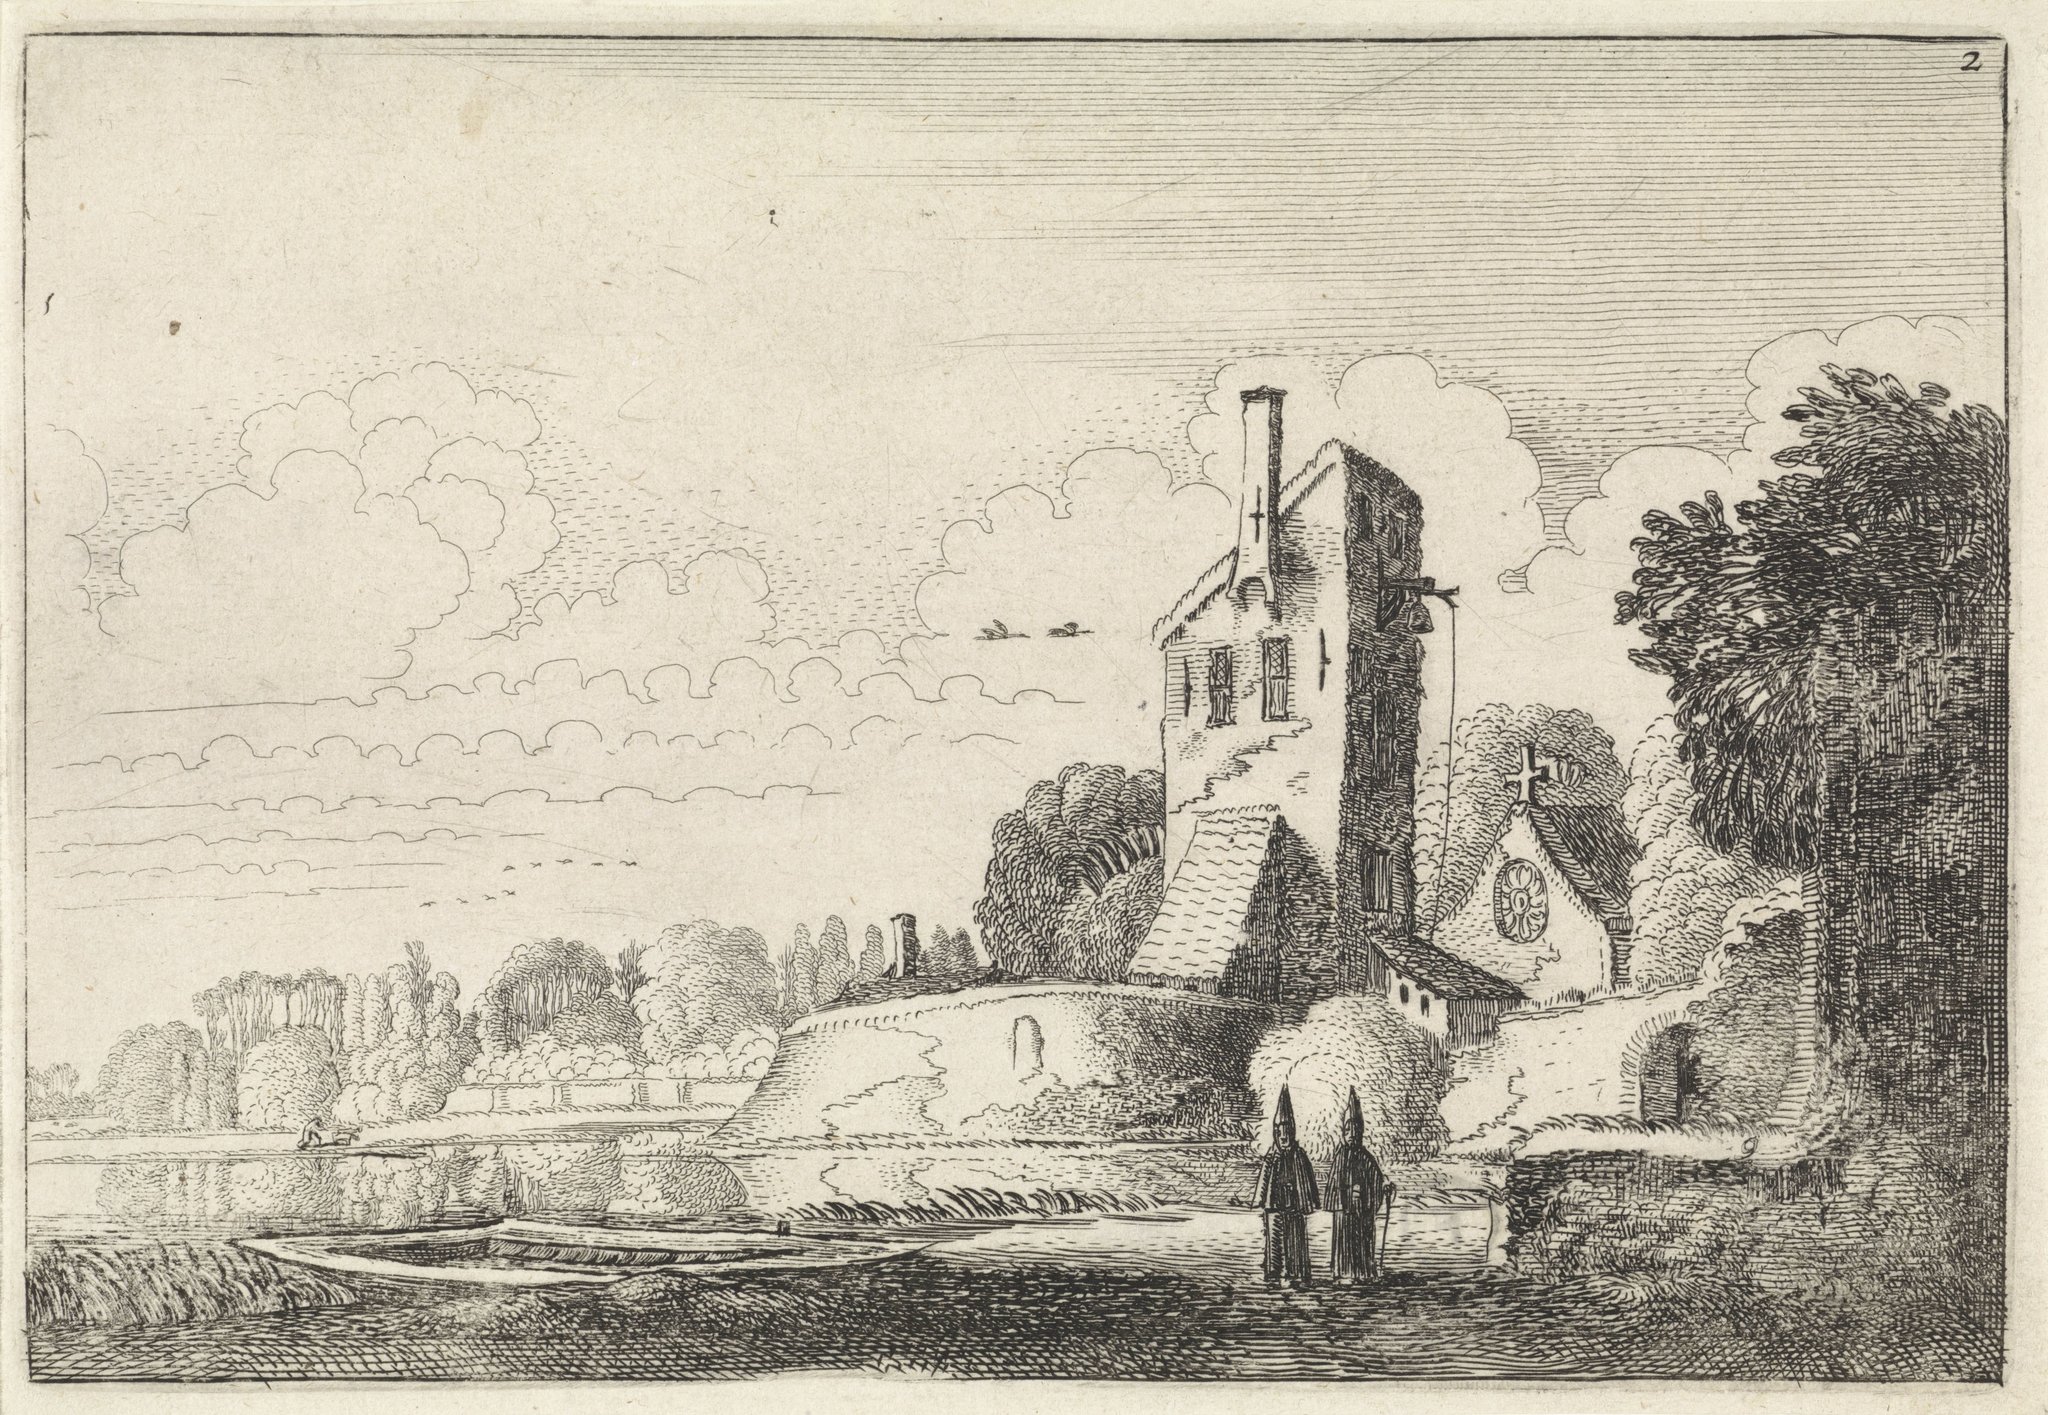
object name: print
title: Amenissimae aliquot requculae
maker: jan van de velde (ii)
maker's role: draughtsman, painter, print maker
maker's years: 1593-1641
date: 1616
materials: paper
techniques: etching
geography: northern netherlands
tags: fortress, church (exterior), monk(s), friar(s), landscape with tower or castle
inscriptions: collector's mark: Lugt 964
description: Landschap met een aan het water gelegen fort met toren. Daarachter een kapel. Op de voorgrond wandelen twee kloosterlingen over een pad. Negende prent van deel twee van een serie van in totaal zestig prenten met landschappen, verdeeld over vijf delen van elk twaalf prenten.